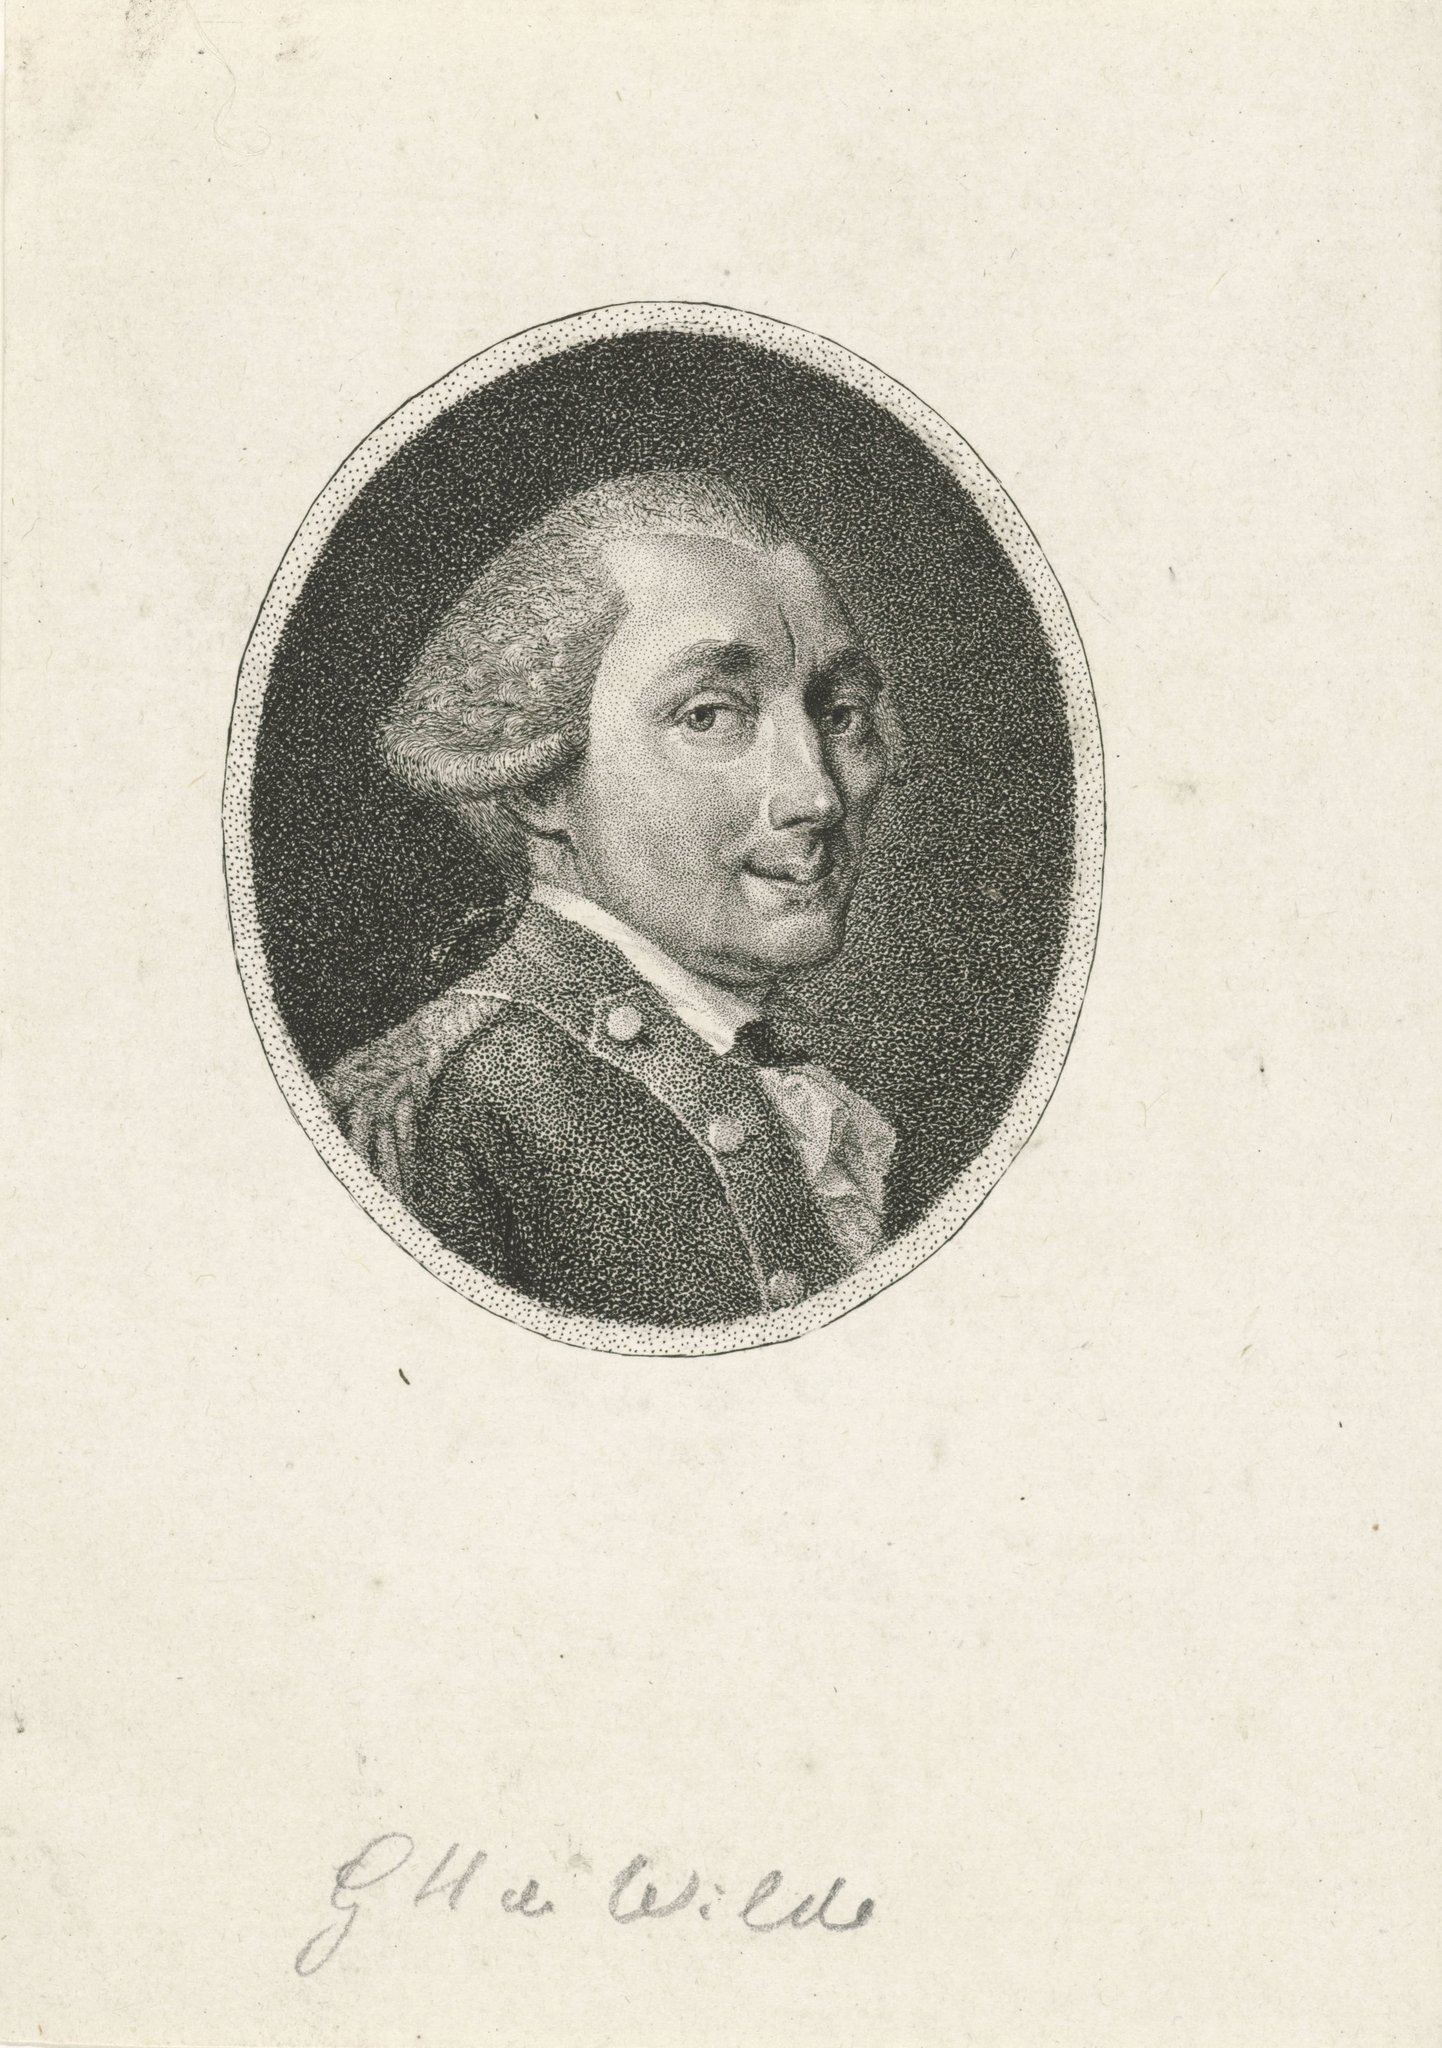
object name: print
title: Portret van George Hendrik de Wilde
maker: françois joseph pfeiffer (i)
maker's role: print maker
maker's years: 1741-1807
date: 1787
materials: paper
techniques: aquatint, etching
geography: amsterdam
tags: luitenant-kolonel, george hendrik de wilde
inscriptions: collector's mark: Lugt 2228